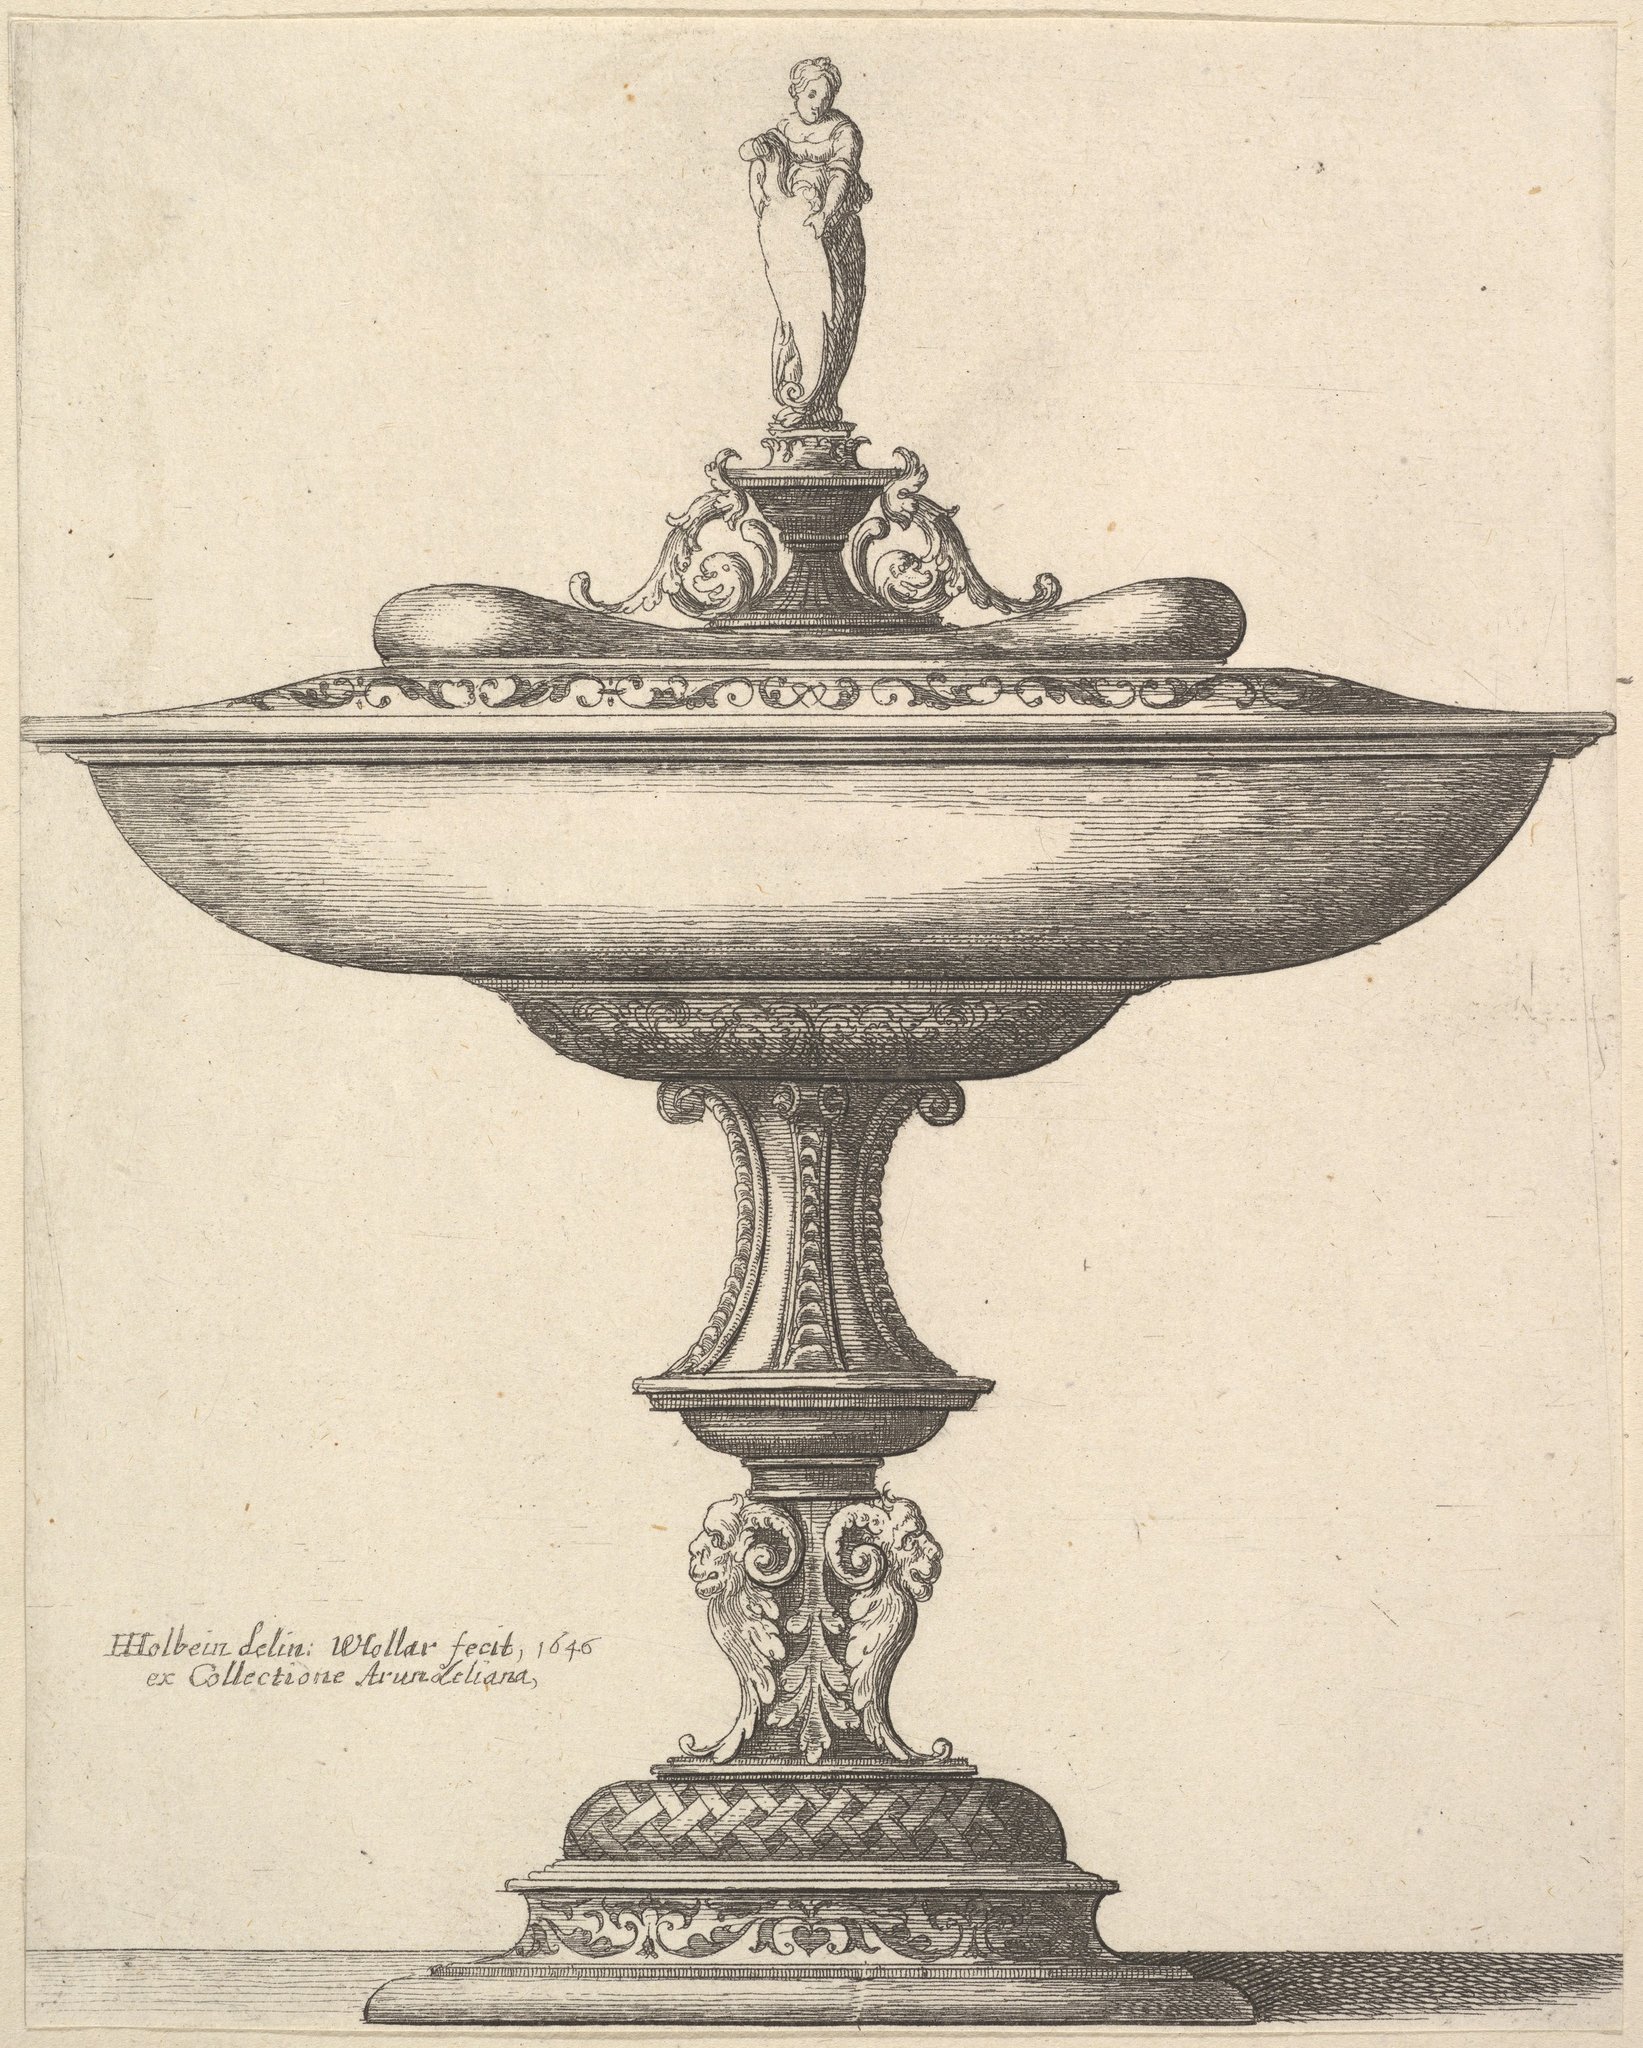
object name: print ornament architecture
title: A wide cup with ornamental stem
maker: wenceslaus hollar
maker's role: artist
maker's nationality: bohemian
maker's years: 1607-1677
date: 1646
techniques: etching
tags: women,cups